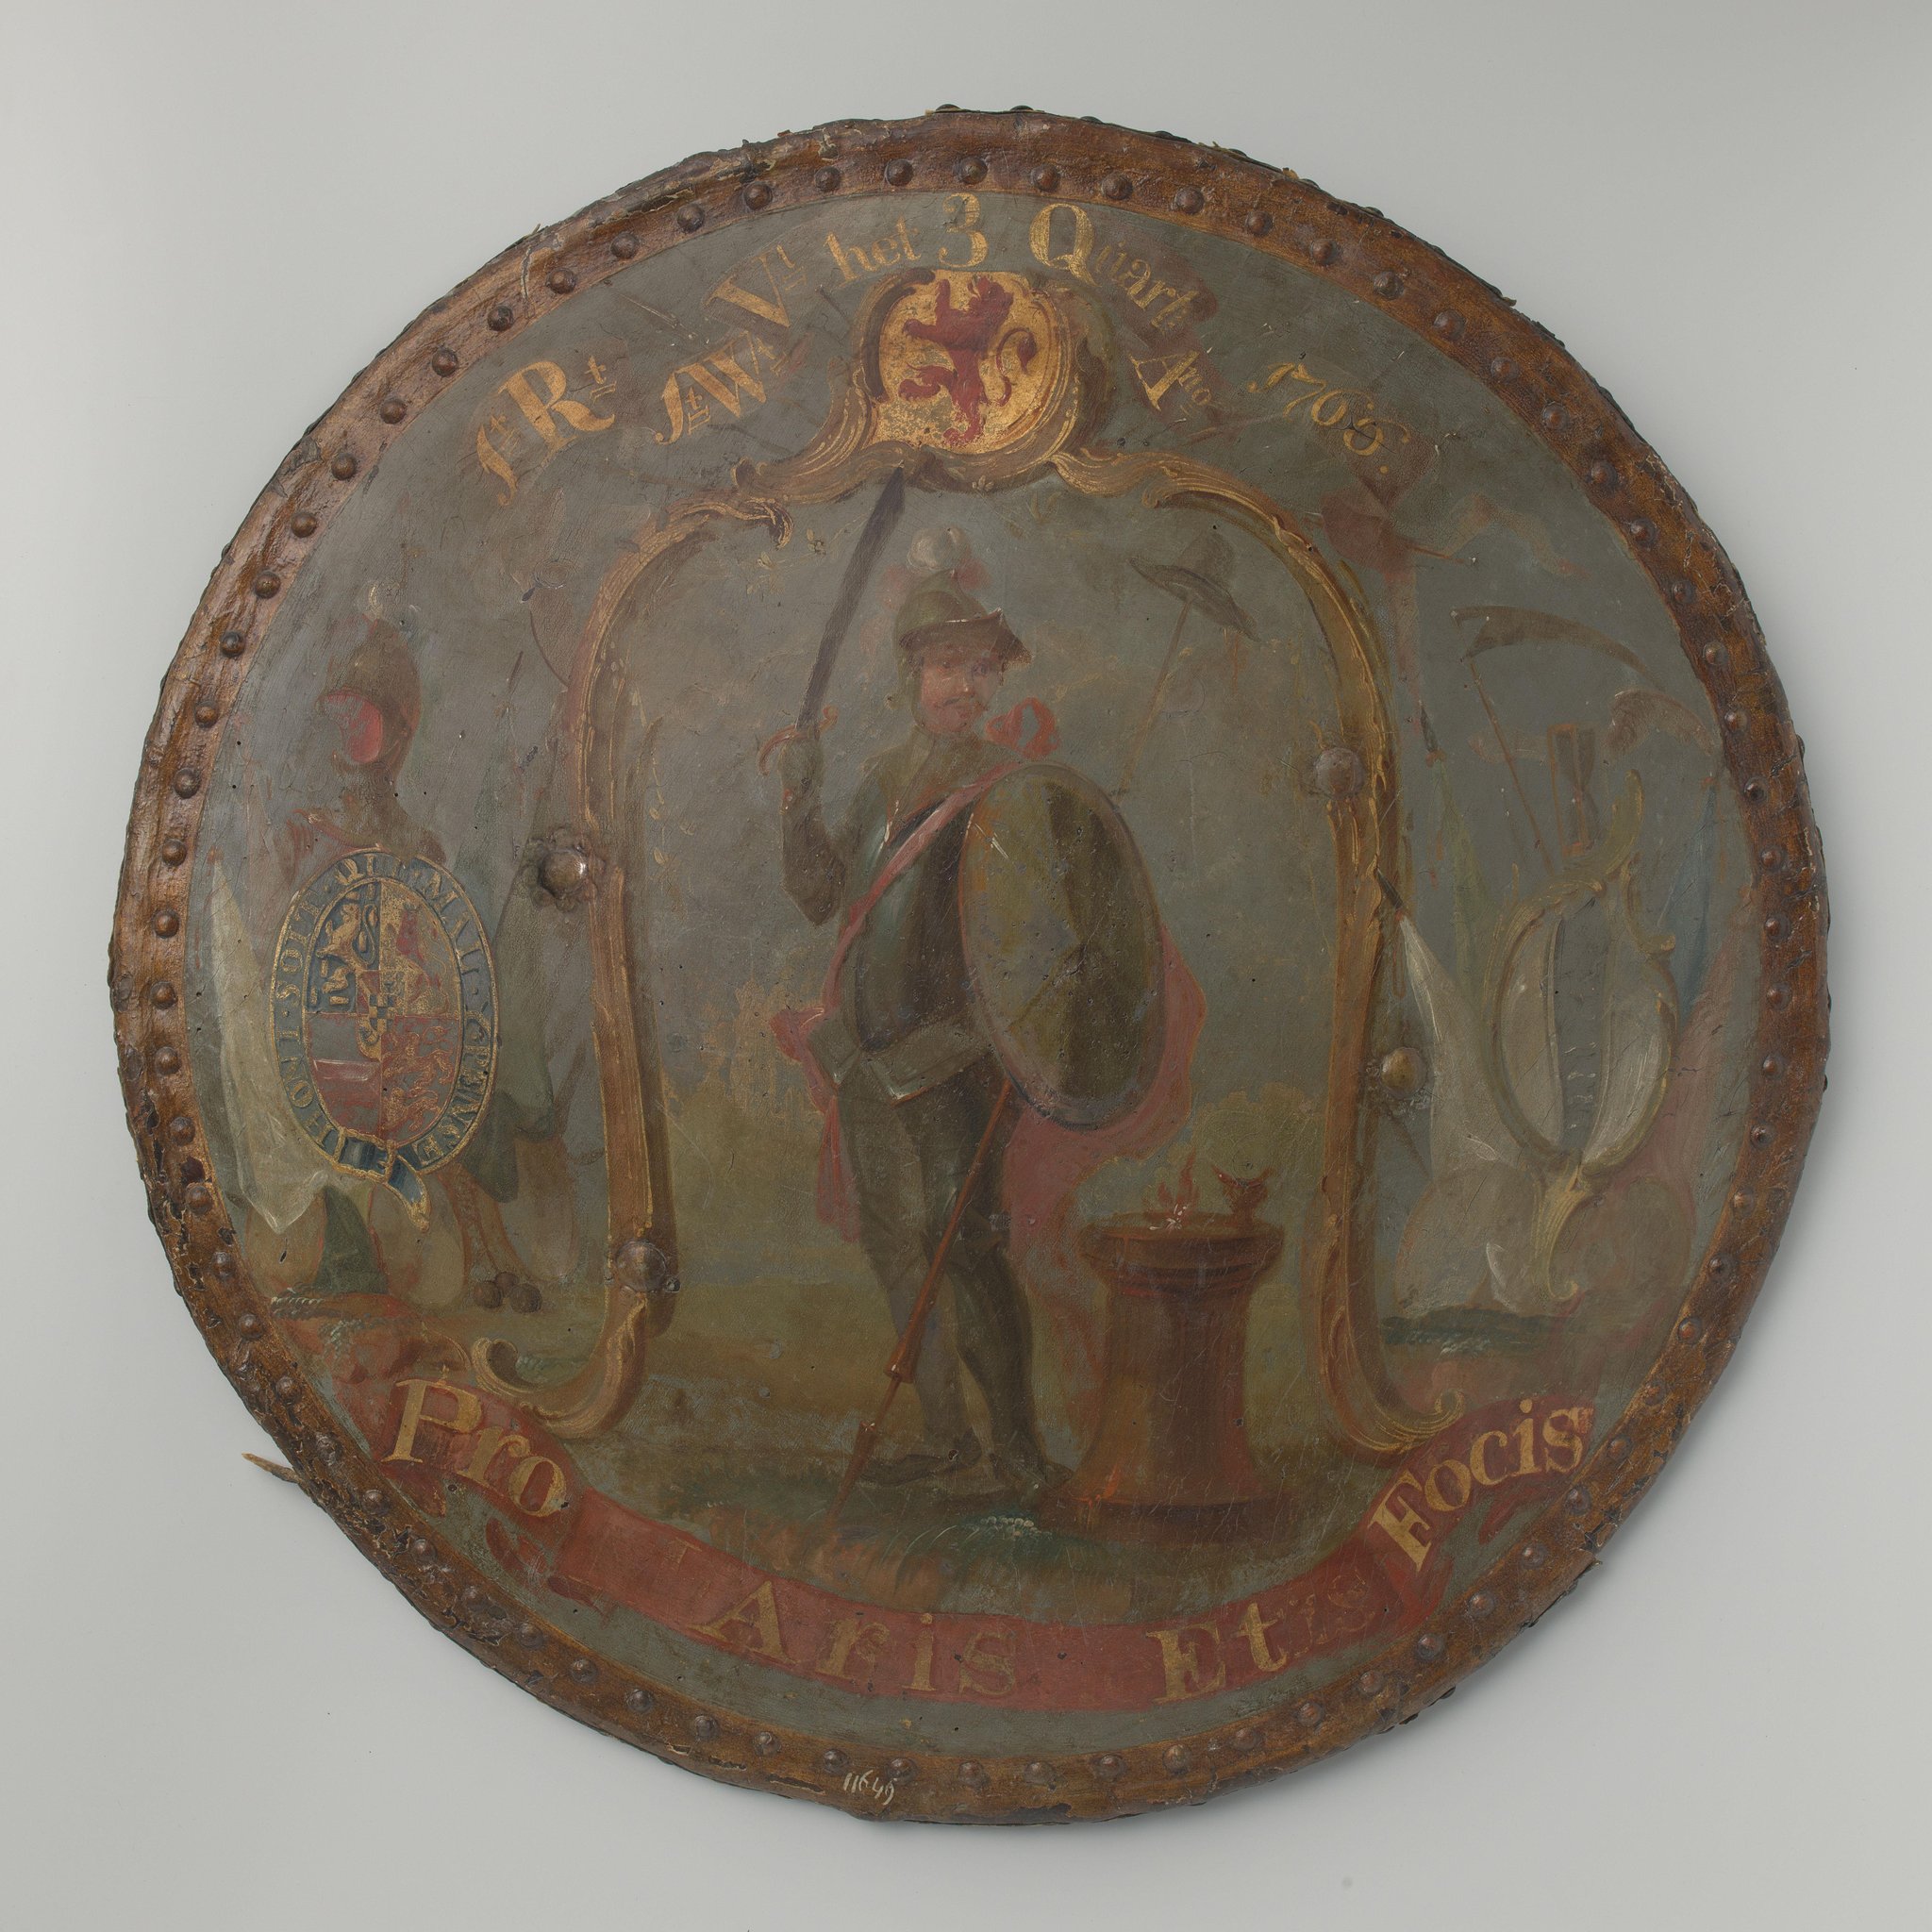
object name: shield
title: Schild beschilderd met een schutter van een Delftse Schutterij, 1766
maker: Anonymous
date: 1766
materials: hair, iron, leather, paint, fiber, wood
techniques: cutting, nailed, painted, tanning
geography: netherlands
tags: delft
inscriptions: date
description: Een rond leren schild met centraal een militair in harnas met zwaard in zijn linker- en lans in zijn rechterhand. Op de lans een hoed. De man draagt een rode sjerp en is omgegeven door een met goudverf aangehechte boog met middenboven het wapen van Holland. Links van hem een wapen met erop een bovenstuk van een harnas. Rechts van hem een altaar waarop een beker. Gedateerd: 1766. Opschrift; m.o.: Pro Aris et focis. m.b.: St Rt St Wt Vt het 3 quart Ao 1766. l.m.: HONI SOIT QUI MAL Y PENSE. Gemerkt.